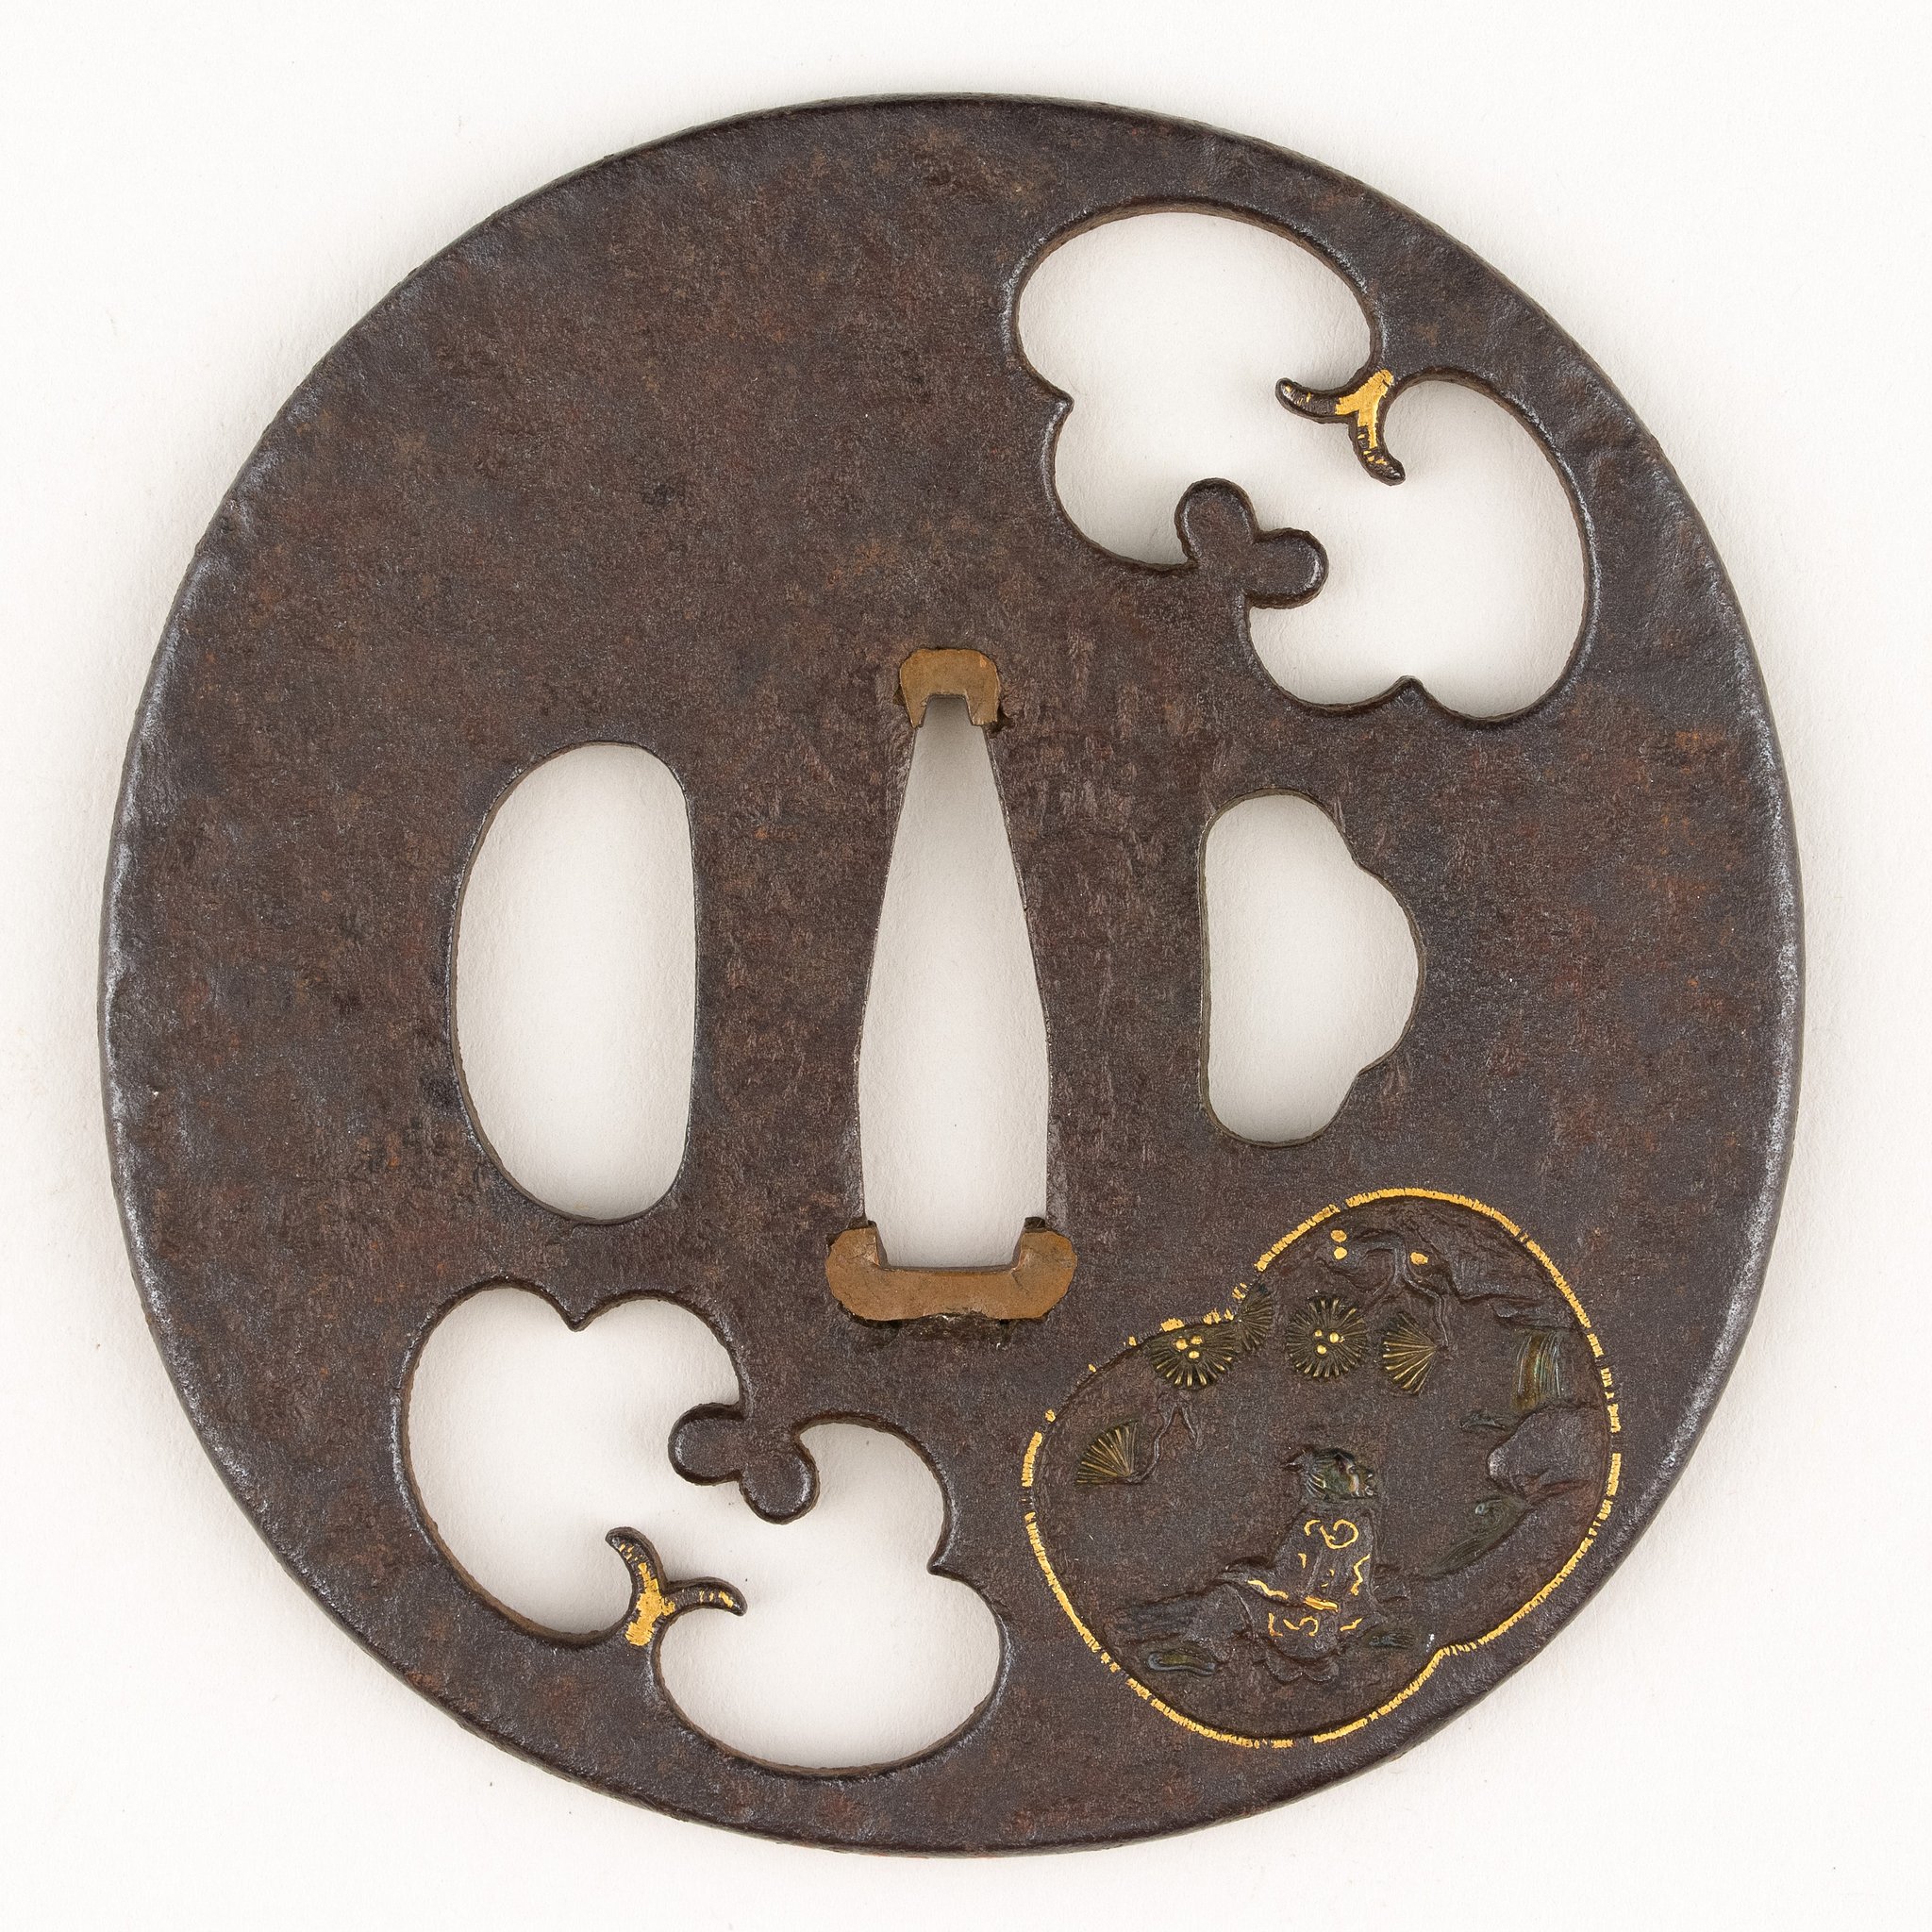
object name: sword guard tsuba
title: Sword Guard (Tsuba)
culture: japanese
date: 1501-1900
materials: gold, iron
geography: japan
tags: men